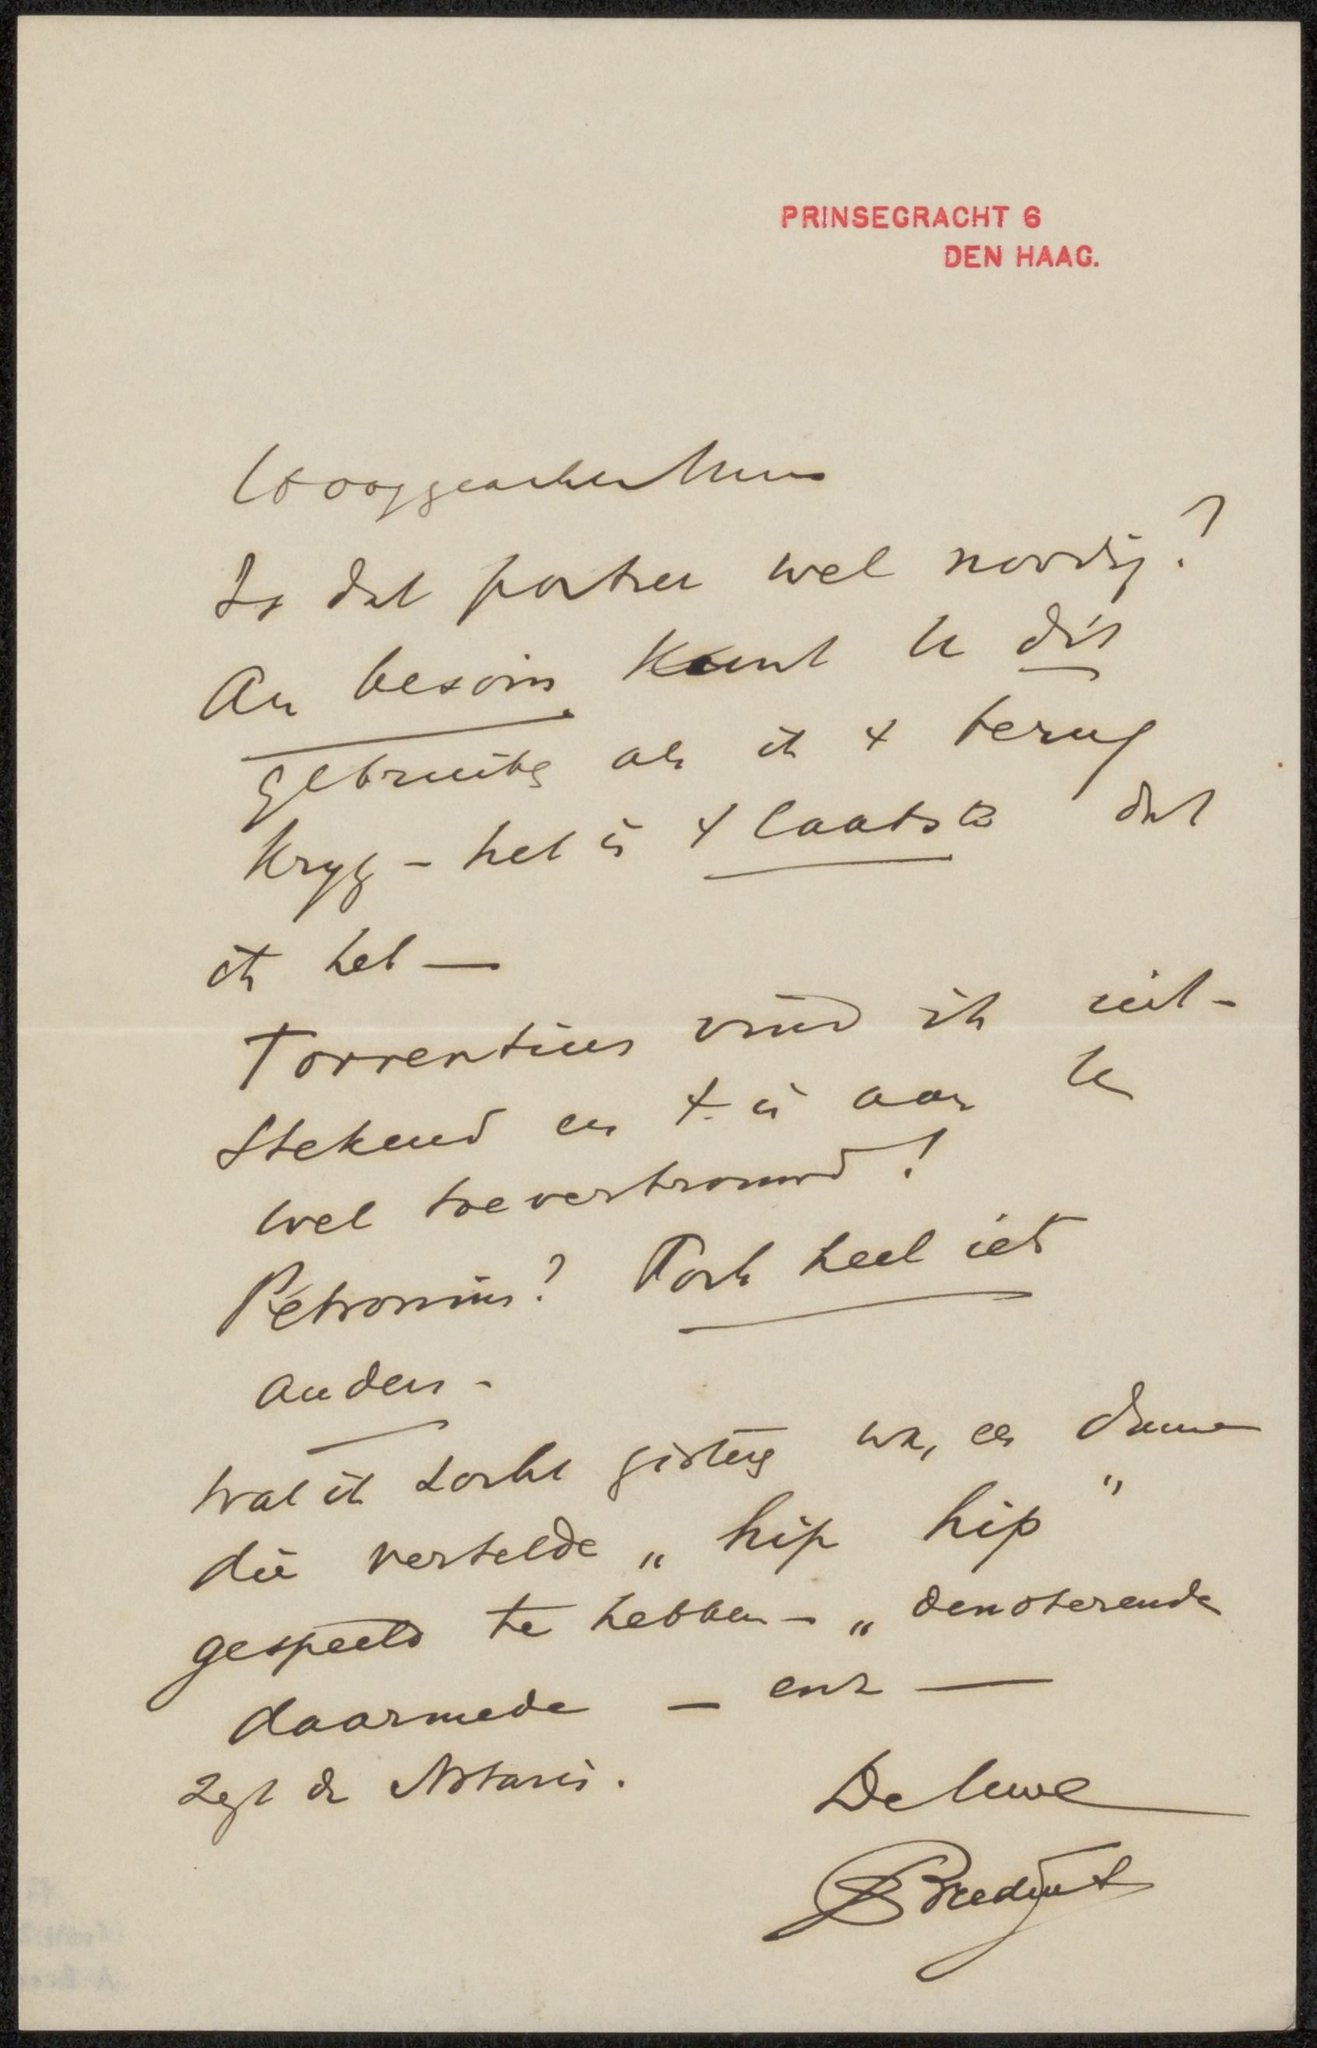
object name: letter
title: Brief aan Philip Zilcken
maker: abraham bredius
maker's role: kunsthistoricus, museumdirecteur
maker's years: 1855-1946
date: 1867-1930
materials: ink, paper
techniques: pen, printing, writing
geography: the hague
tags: painter, draughtsman, philip zilcken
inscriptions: collector's mark: ‘RPK’